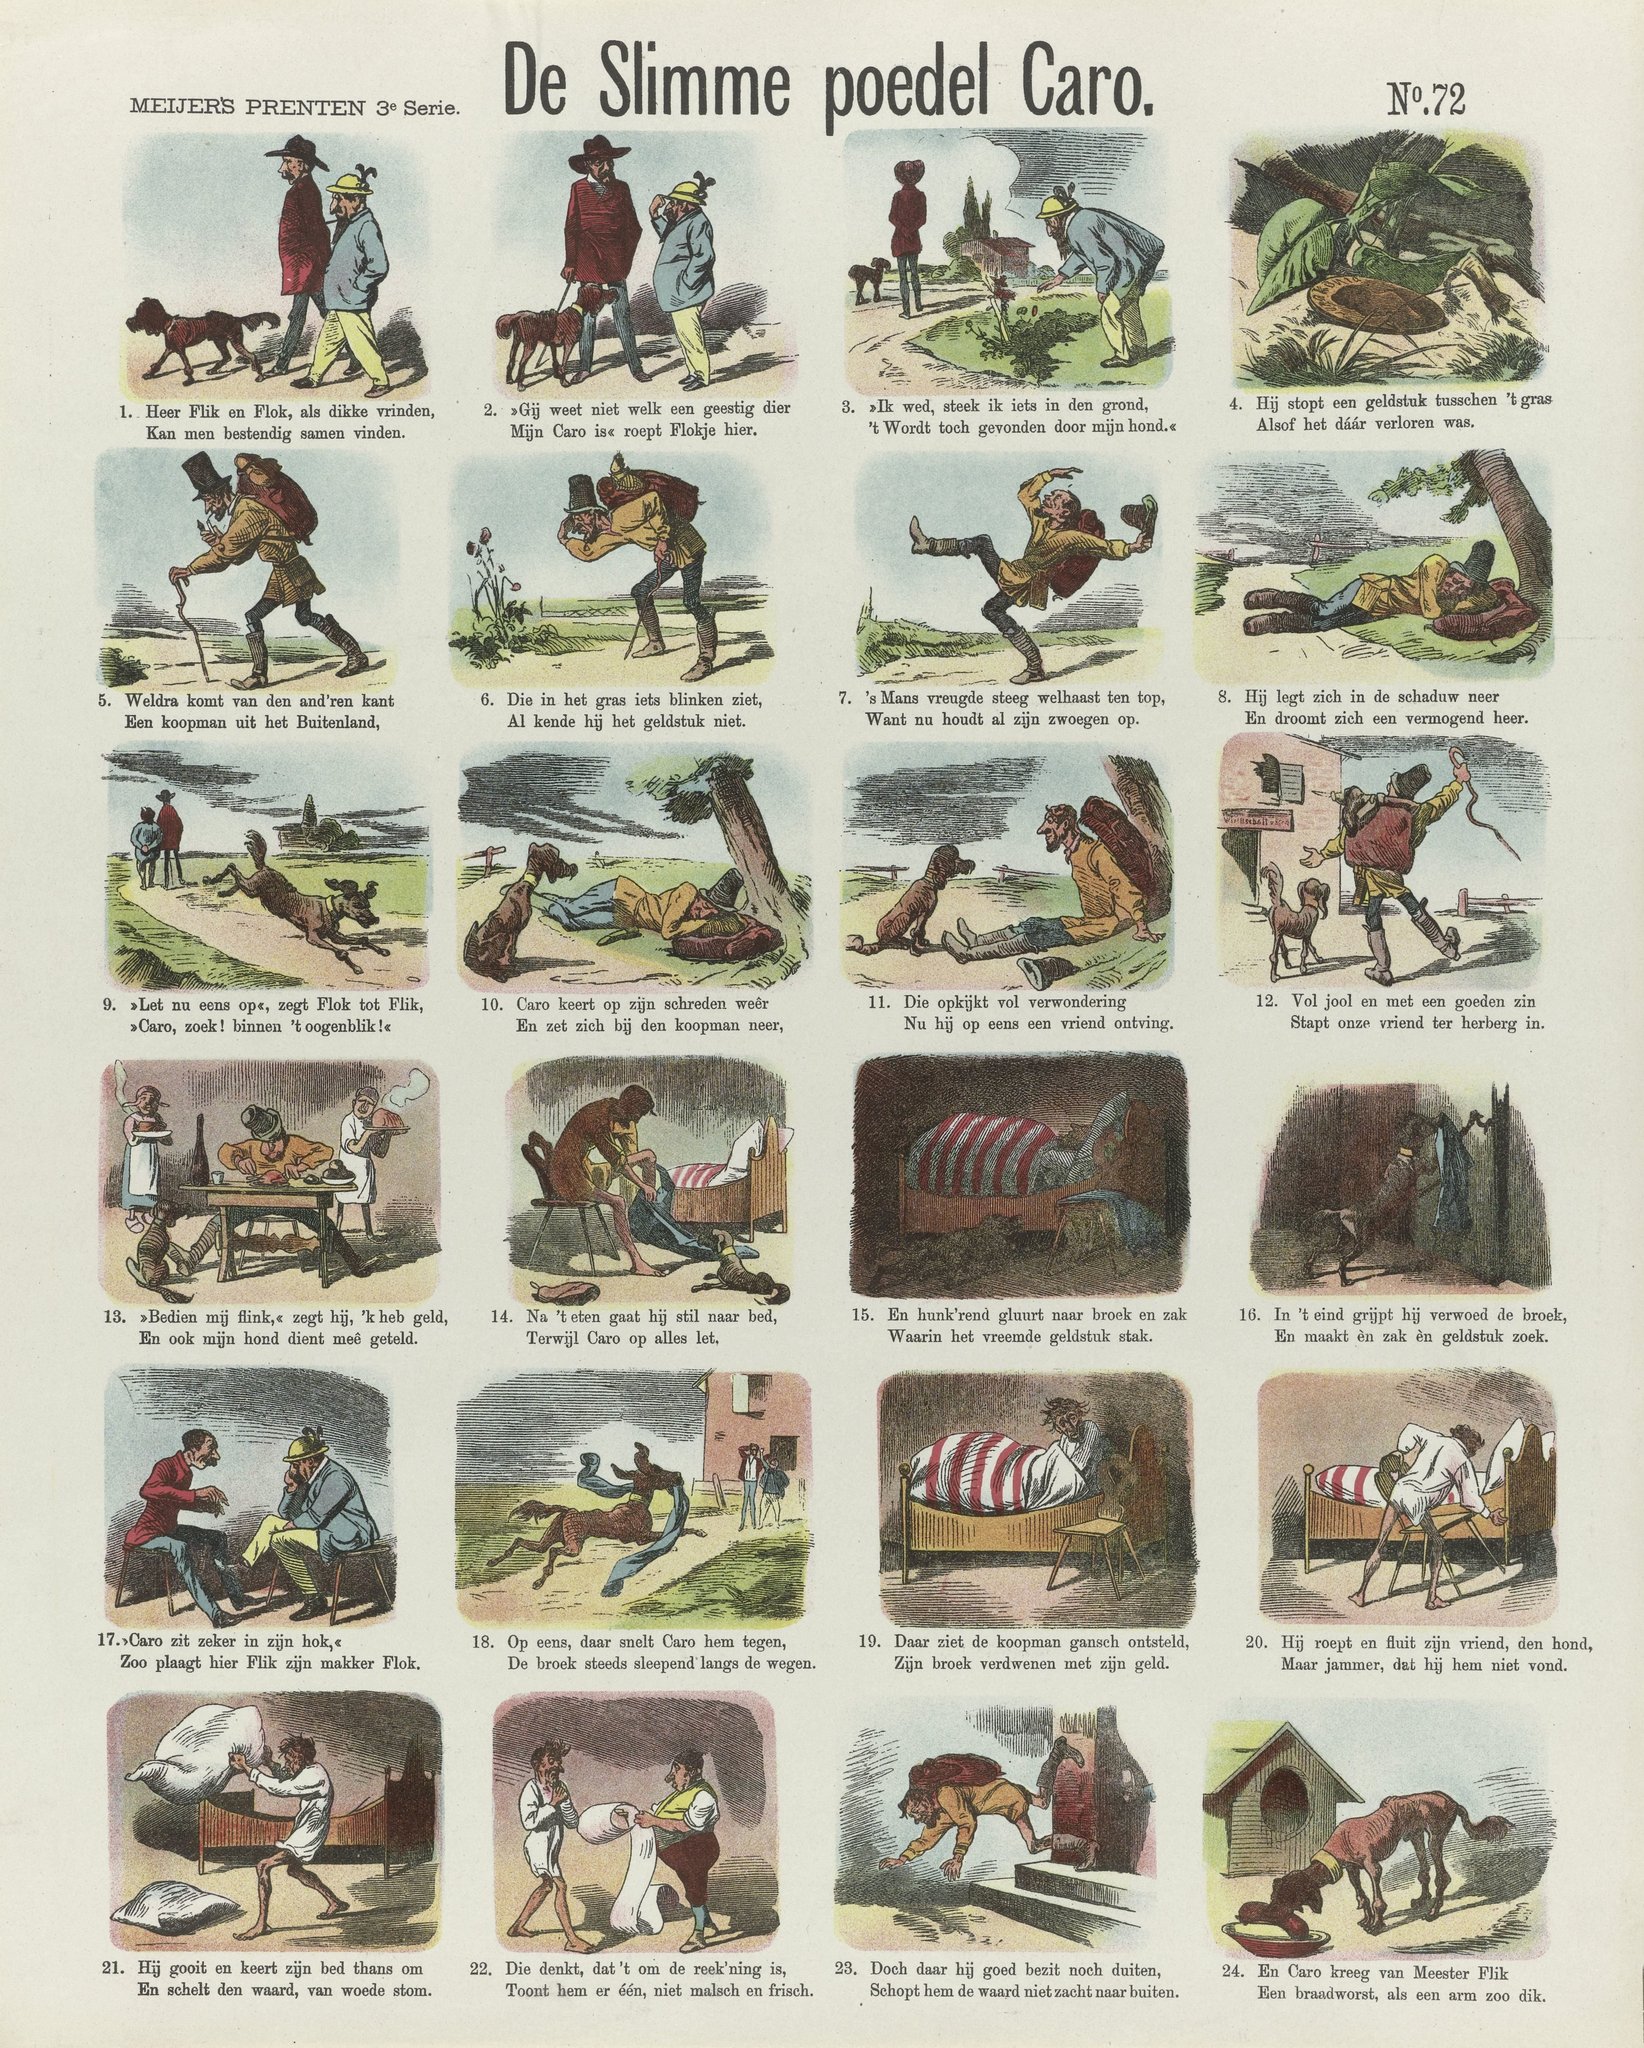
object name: popular print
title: Meijer's prenten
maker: Anonymous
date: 1878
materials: paper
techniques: lithograph, letterpress printing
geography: amsterdam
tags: walking the dog, hotel, hostelry, inn, dog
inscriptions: collector's mark: Lugt 2760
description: Blad met 24 voorstellingen over de slimme poedel Caro die de rijksdaalder van zijn baasje terugvindt. Onder elke afbeelding een tweeregelig vers. Genummerd rechtsboven: No. 72.